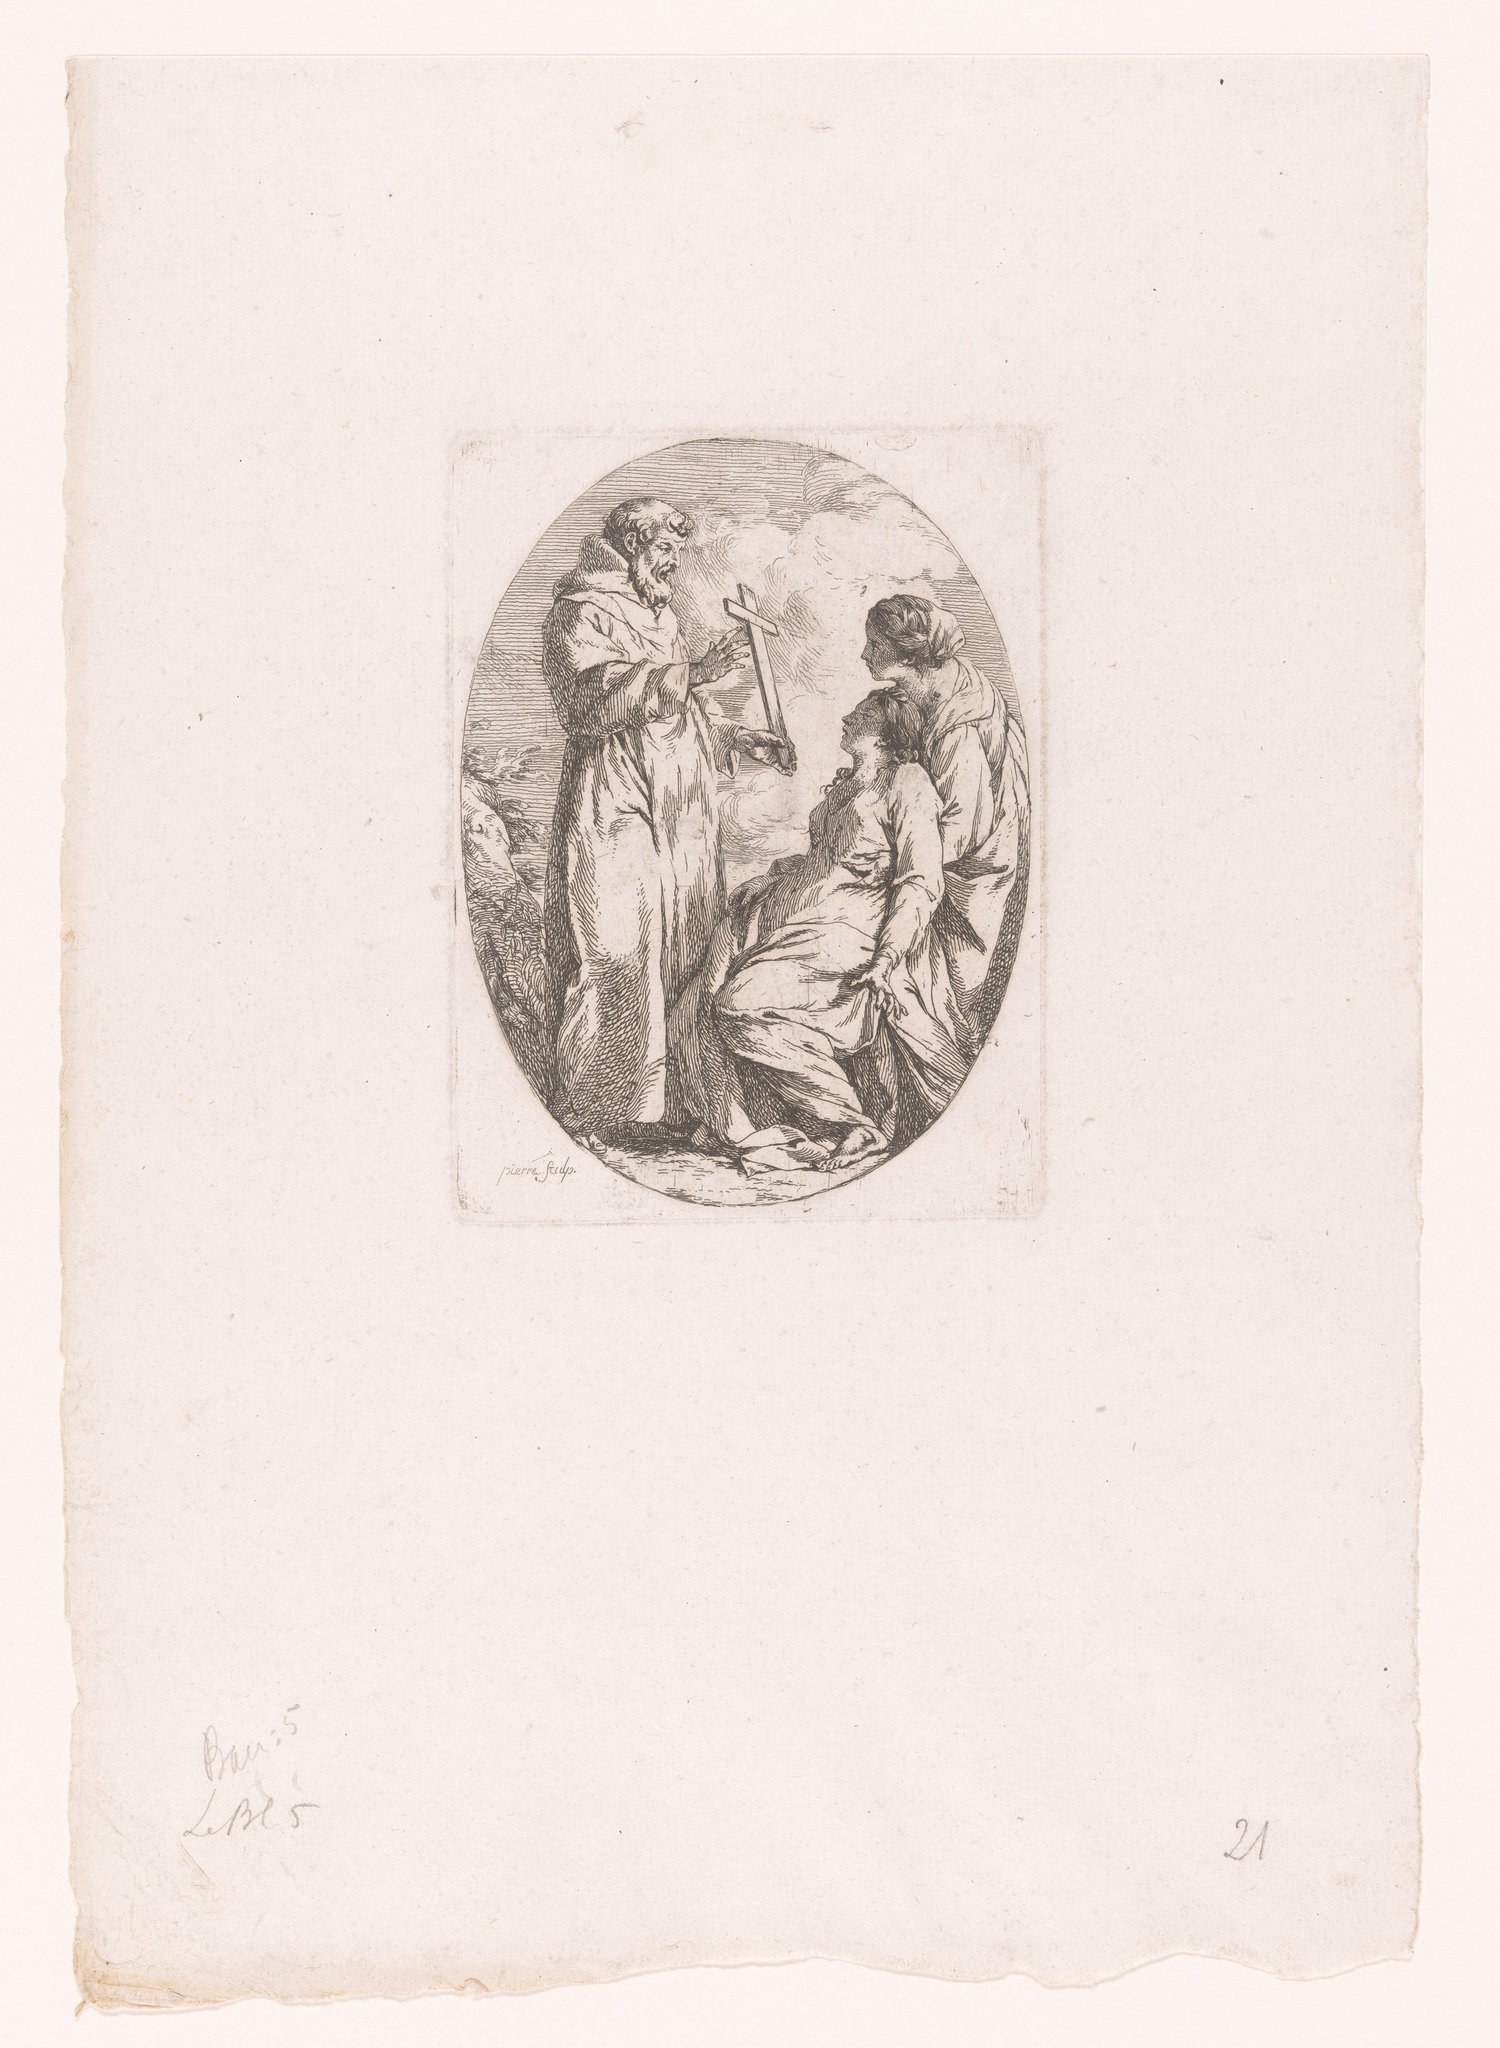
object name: print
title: Heilige Franciscus geneest een zieke vrouw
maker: jean baptiste marie pierre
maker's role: print maker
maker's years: 1713-1789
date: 1740-1750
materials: paper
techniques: etching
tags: miraculous activities and events ~ st. francis of assisi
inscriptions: collector's mark: Lugt 2228